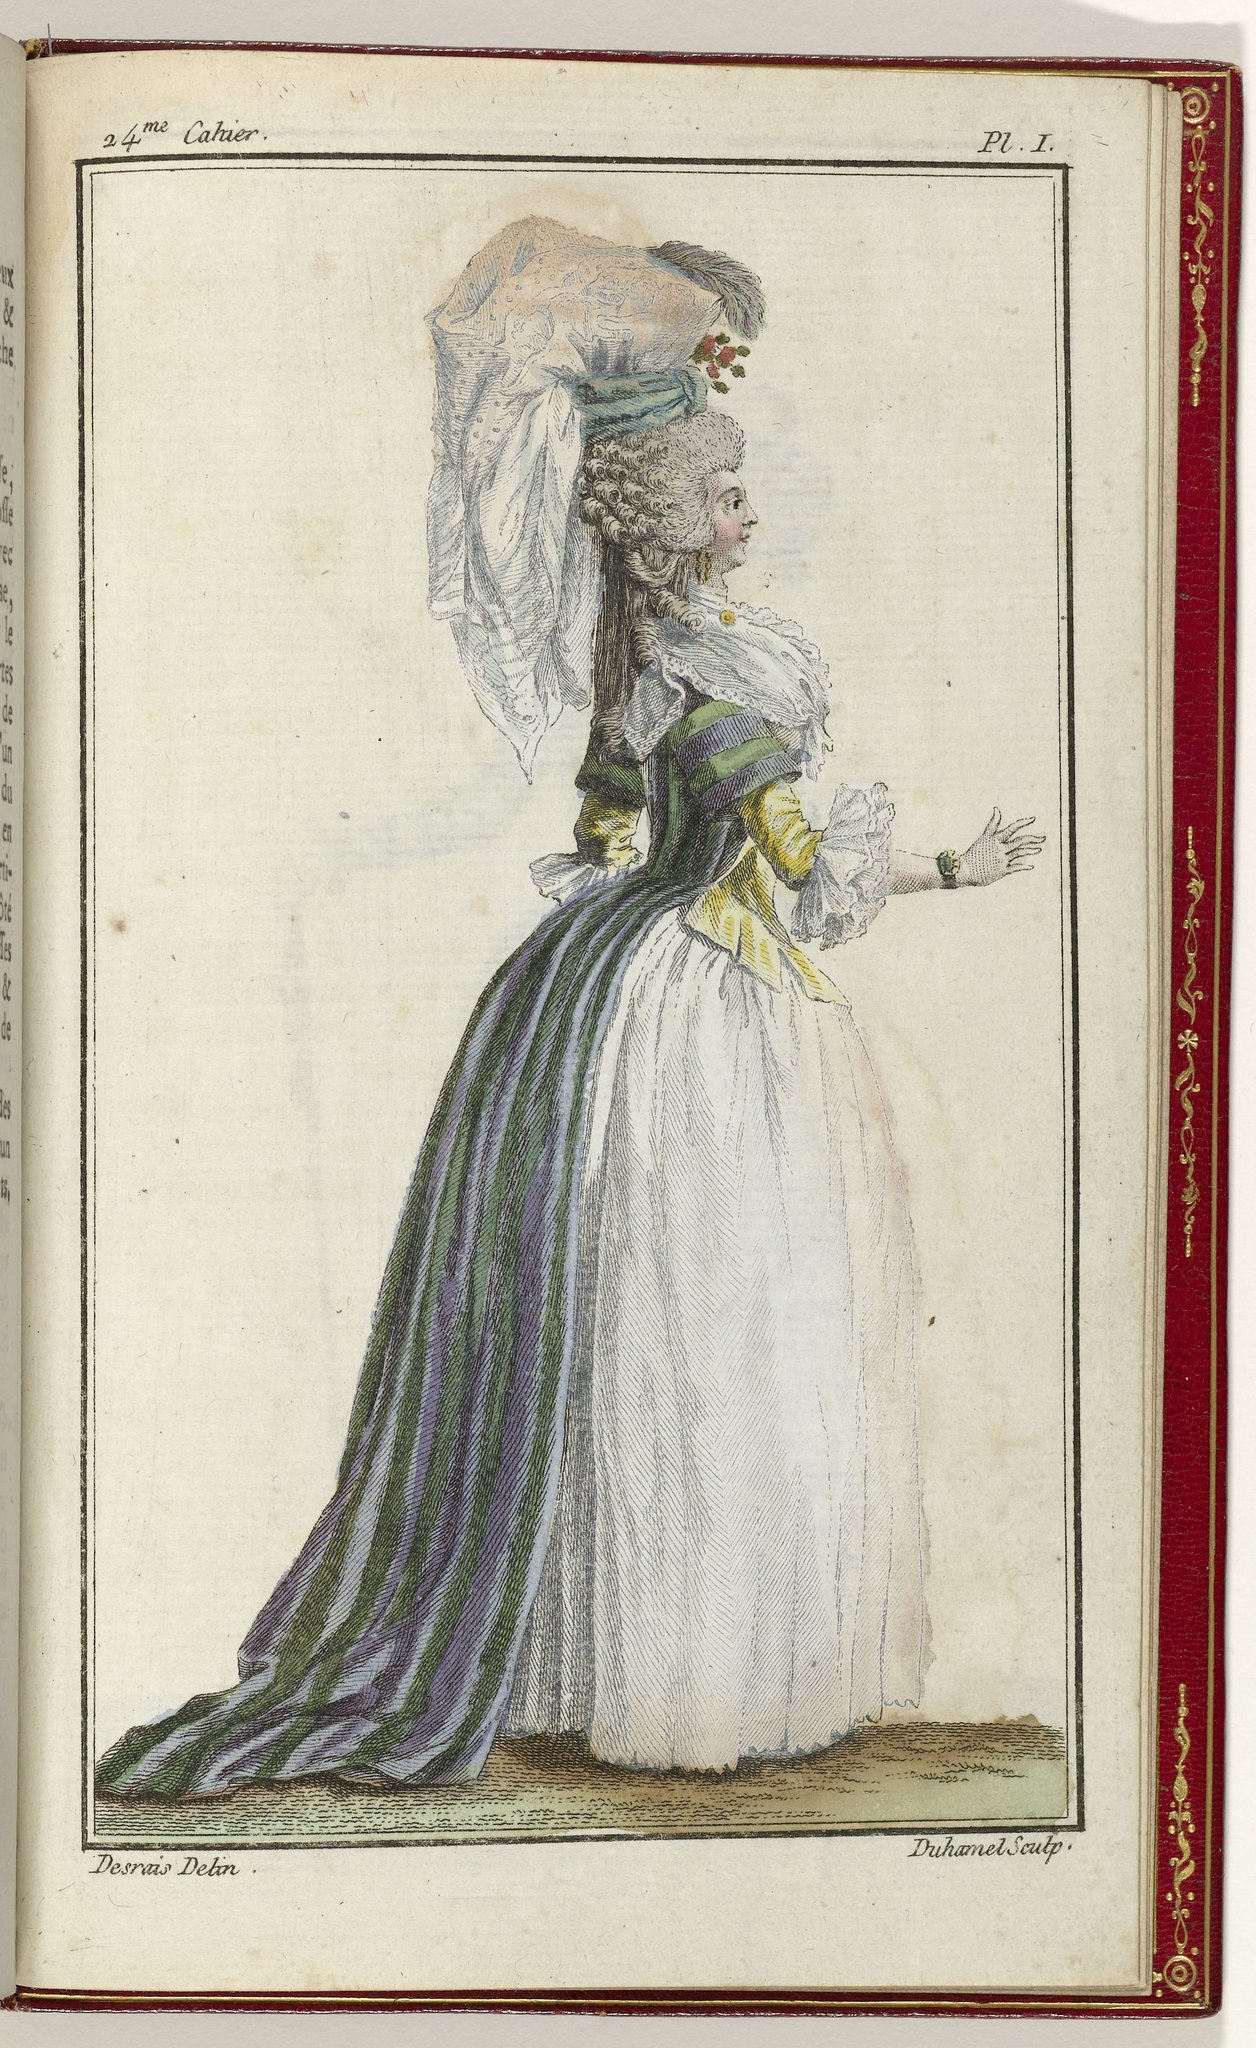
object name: fashion print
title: Cabinet des Modes ou les Modes Nouvelles, 1 Novembre 1786, pl. I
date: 1786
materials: paper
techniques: engraving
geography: paris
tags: ear-rings (+ women's clothes), dress, gown (robe à la turque) (+ women's clothes), styles of hairdress - aa - ~ women, head-gear: cap (+ women's clothes), fashion plates, piece of clothing covering the breast or décolleté (fichu) (+ women's clothes), bracelet, wristlet (+ women's clothes)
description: Robe à la Turque. Volgens de begeleidende tekst is de vrouw gekleed in een "robe à la Turque" van gestreept satijn met sleep. Hierbij draagt zij een fichu, een lijfje met driekwart mouwen met dubbele manchetten, geplooide kraag en dubbele manchetten en een wit satijnen rok met gefestoneerde zoom. Op het hoofd een "Bonnet à la Turque": een hoge muts van Engelse gaze met een blauwe band van crêpe, waarop een hoge toef van kant , bloemetjes en veren. (De bonnet is van "demoiselle Roussaud, au coin de la rue du Théatre Francais" ). Kapsel van fijne krullen aan de zijkant en lange, losse krullen aan de achterkant. Accessoires: oorbellen, speld met medaillon, armband met medaillon en diamanten. De prent maakt deel uit van het 24e Cahier uit de serie Cabinet des Modes ou les Modes Nouvelles. De serie bestaat uit 72 modeprenten, uitgegeven door Buisson, Parijs, 15 november 1785 - 1 november 1786. (icon aanvullen)